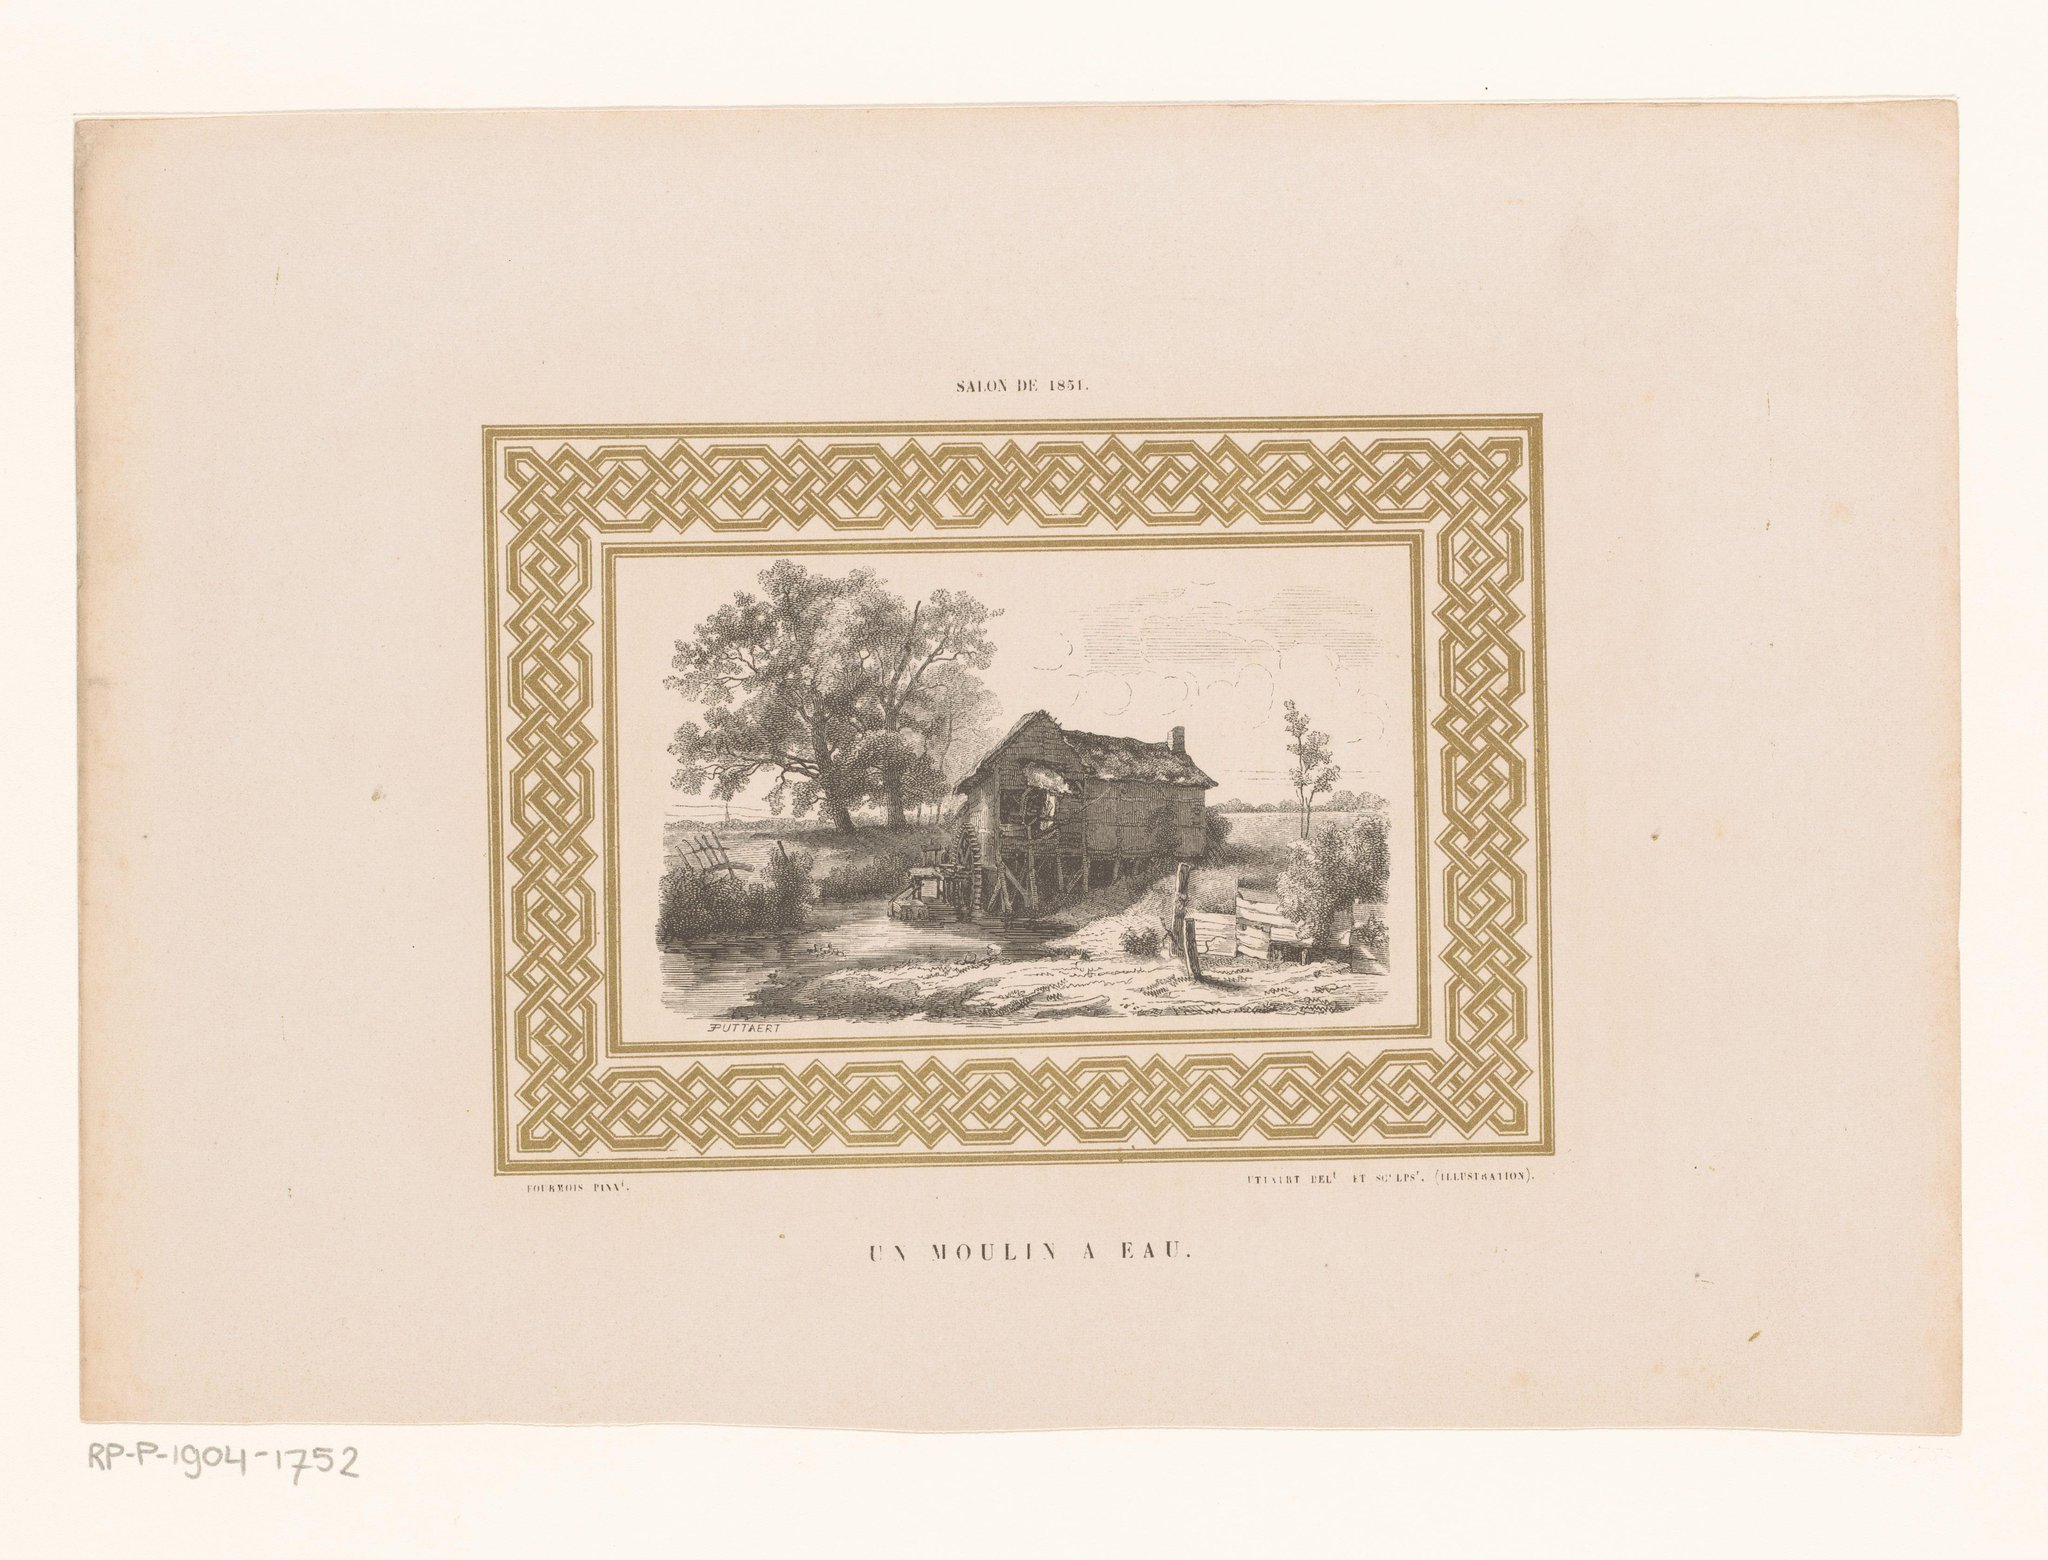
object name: print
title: Un moulin à eau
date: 1851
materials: paper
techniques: engraving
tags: watermill, watermill in landscape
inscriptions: collector's mark: Lugt 2228